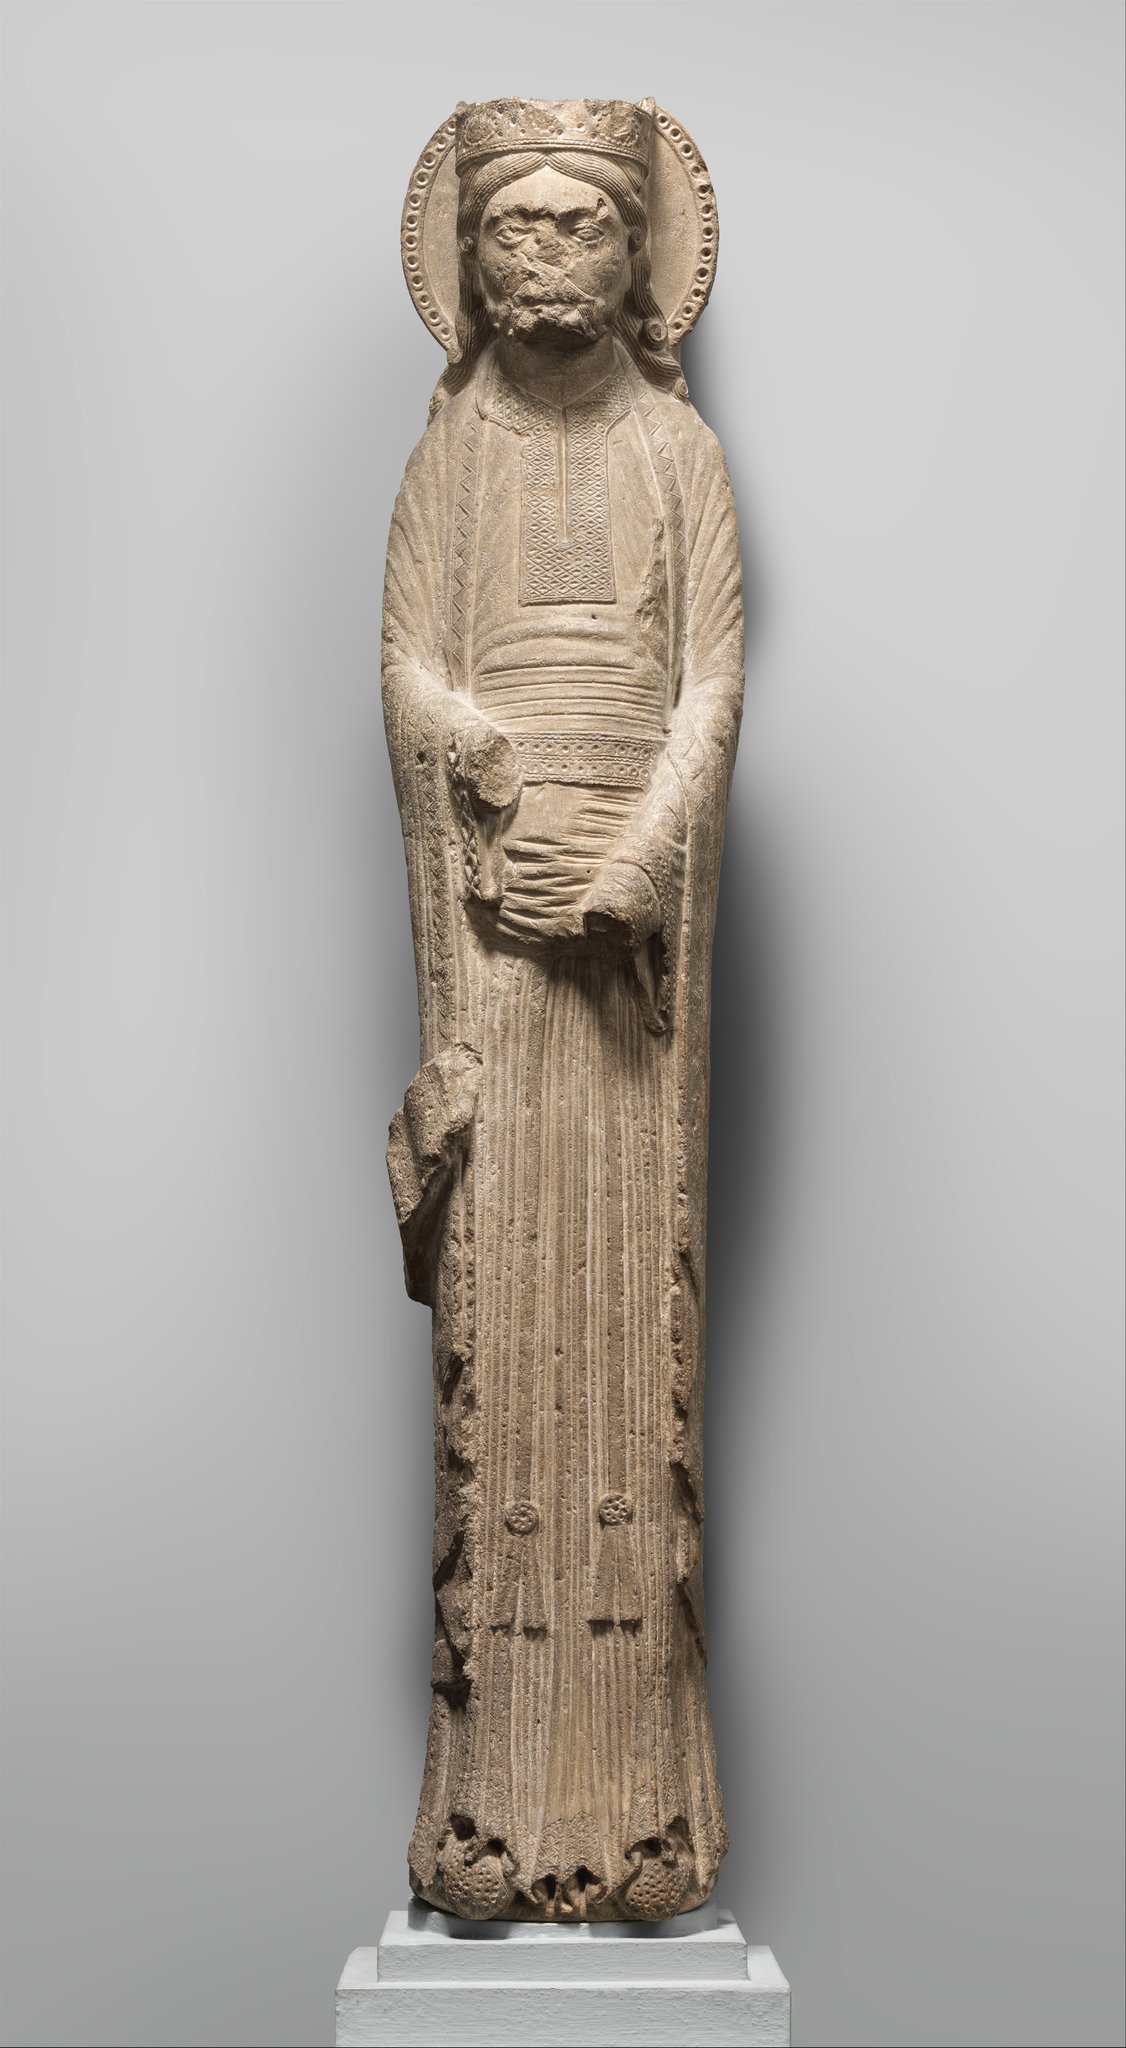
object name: sculpture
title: Column Statue of a King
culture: french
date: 1150-1160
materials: limestone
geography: saint-denis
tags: kings,men